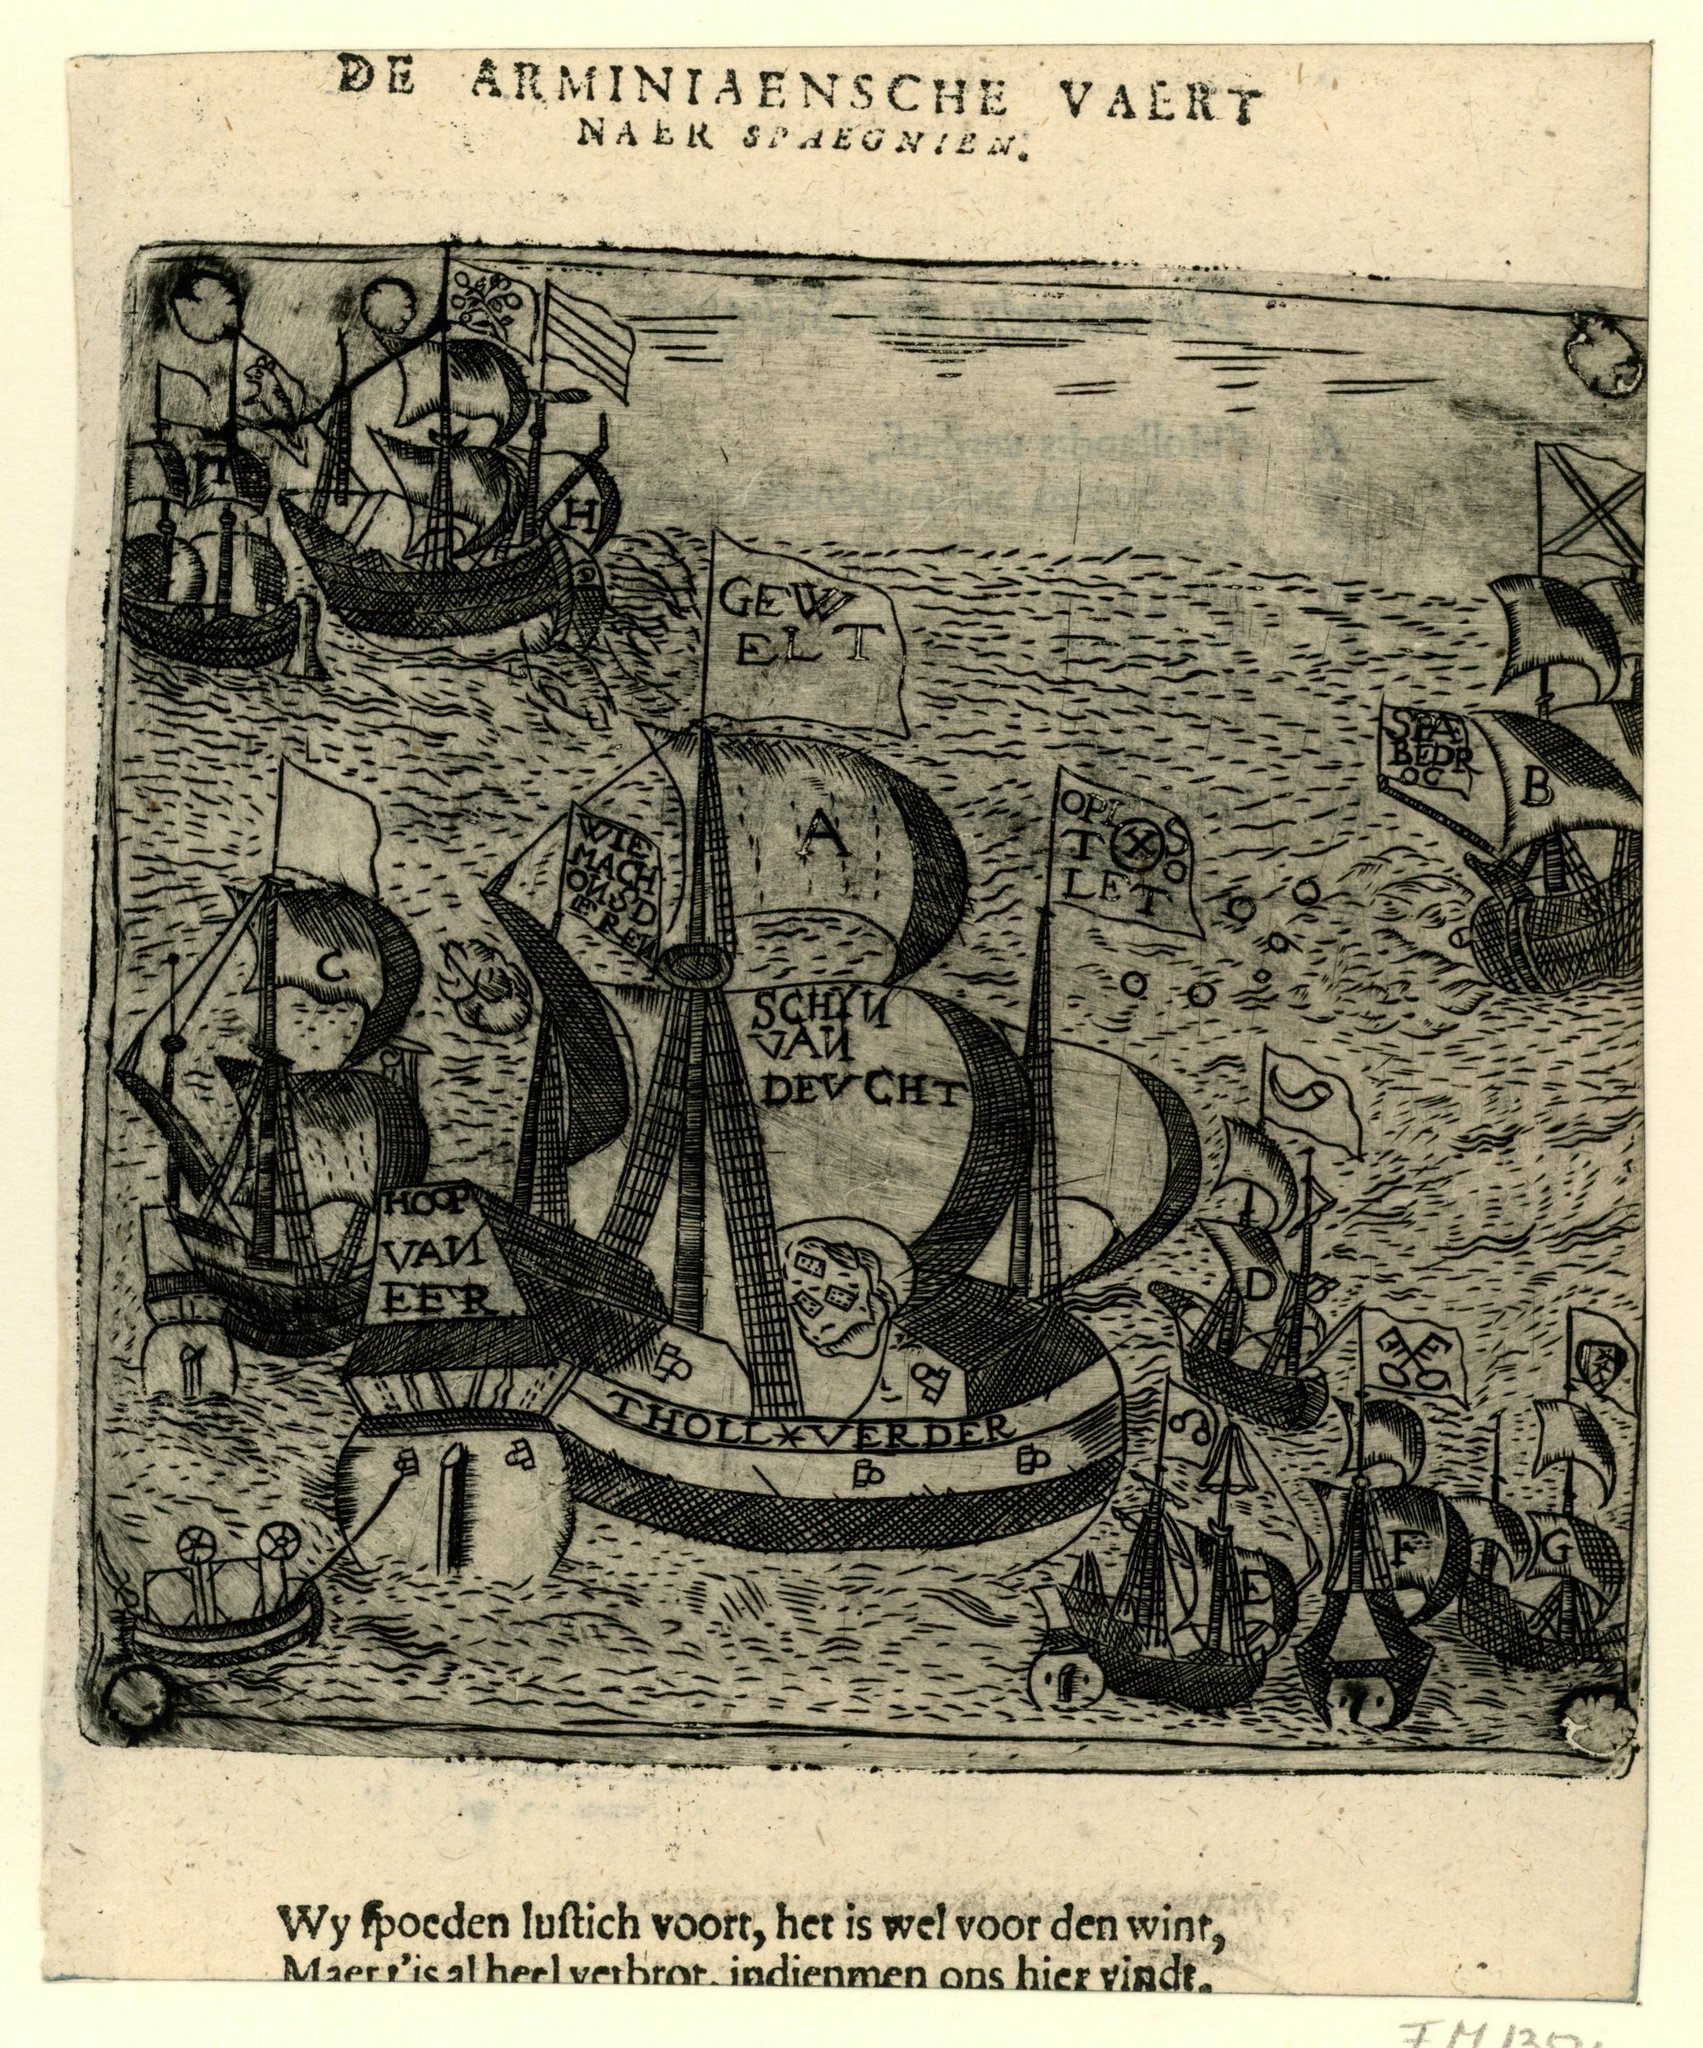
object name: titelprent, frontispice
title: Titelprent voor het pamflet: De Arminiaensche vaert naer Spaegnien, 1618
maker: Anonymous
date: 1618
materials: paper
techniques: engraving, letterpress printing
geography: northern netherlands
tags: ships (in general) (+ propulsion of vehicle, ship, etc. by wind)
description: Titelprent van het pamflet 'De Arminiaensche vaert naer Spaegnien', zonder jaartal of plaats van uitgave [1618]. Spotprent op de val van de arminianen. De voorstelling van deze simpele gravure toont de vaart van het arminiaanse schip naar Spanje. Het schip draagt opschriften als 'Schyn van Deucht' / 'Tholl*Verder' / 'Hoop van Eer' / 'Wie Mach Ons Dieren'. In de nabijheid van het schip varen andere schepen met de wapens van onder andere Leiden en Gouda. Rechtsboven het schip 'Spae[ns] Bedrog'. Onder de voorstelling een vers van twee regels in het Nederlands.